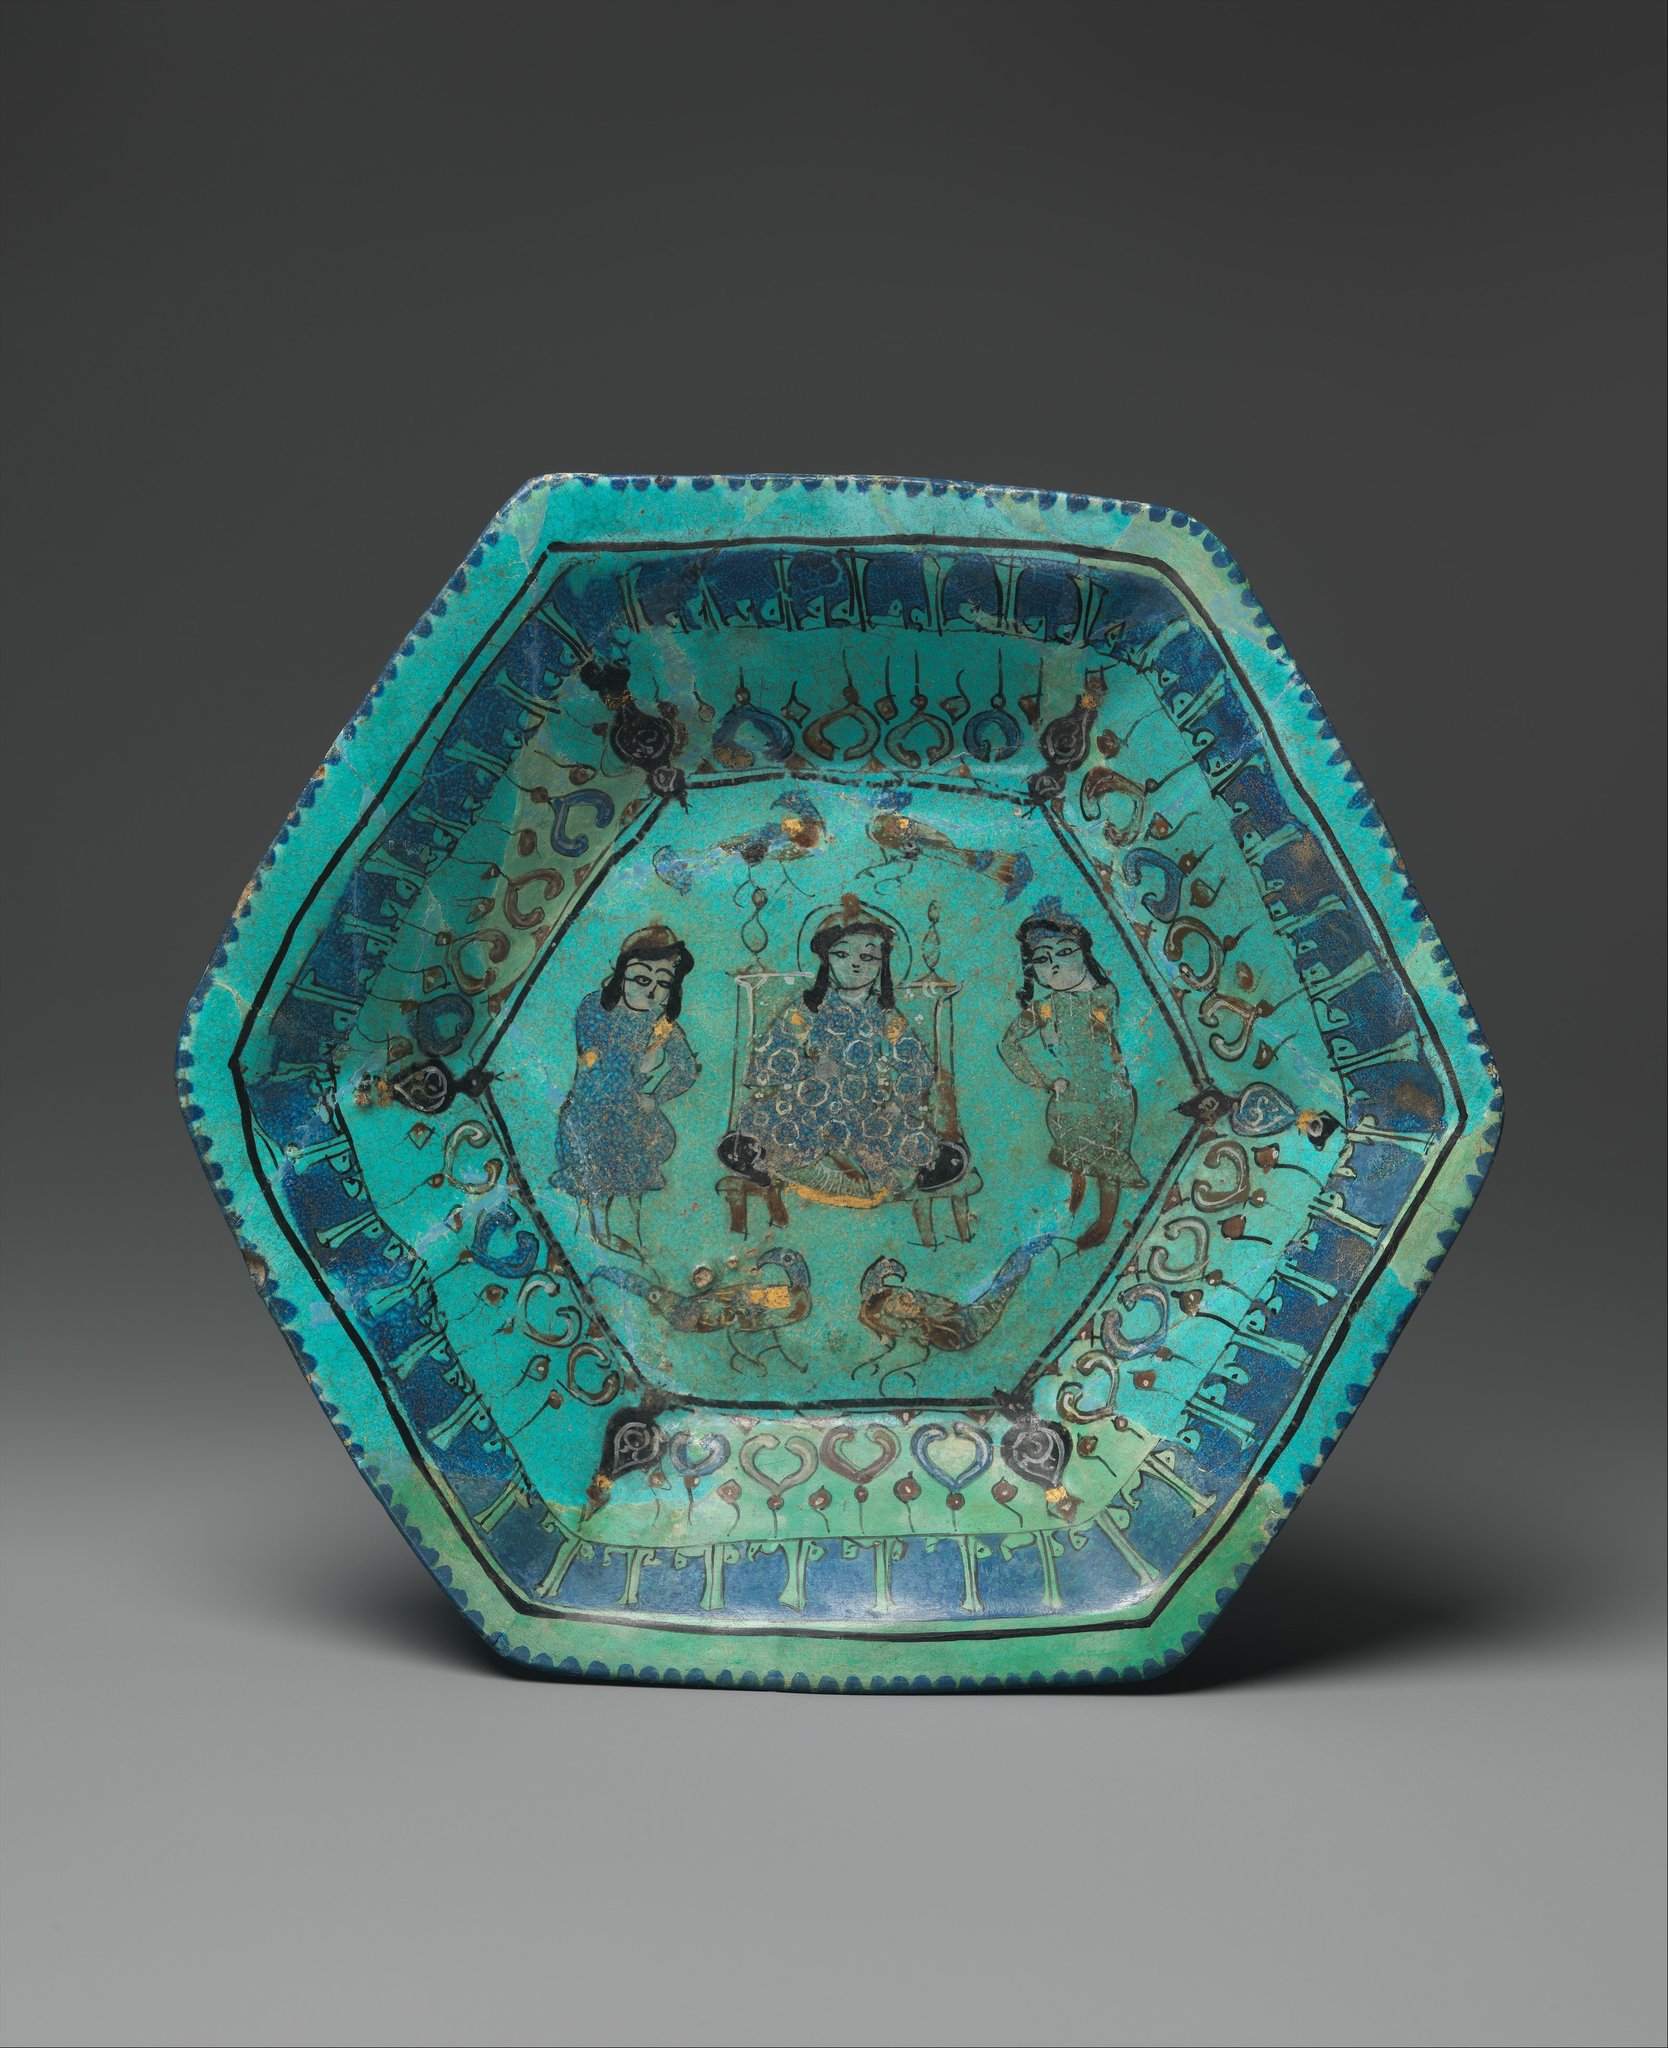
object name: bowl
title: Bowl with Enthroned Figure, Attendants, and Peacocks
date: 1101-1300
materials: glaze, stonepaste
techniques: glazing, overglaze, painting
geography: iran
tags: human figures,peacocks